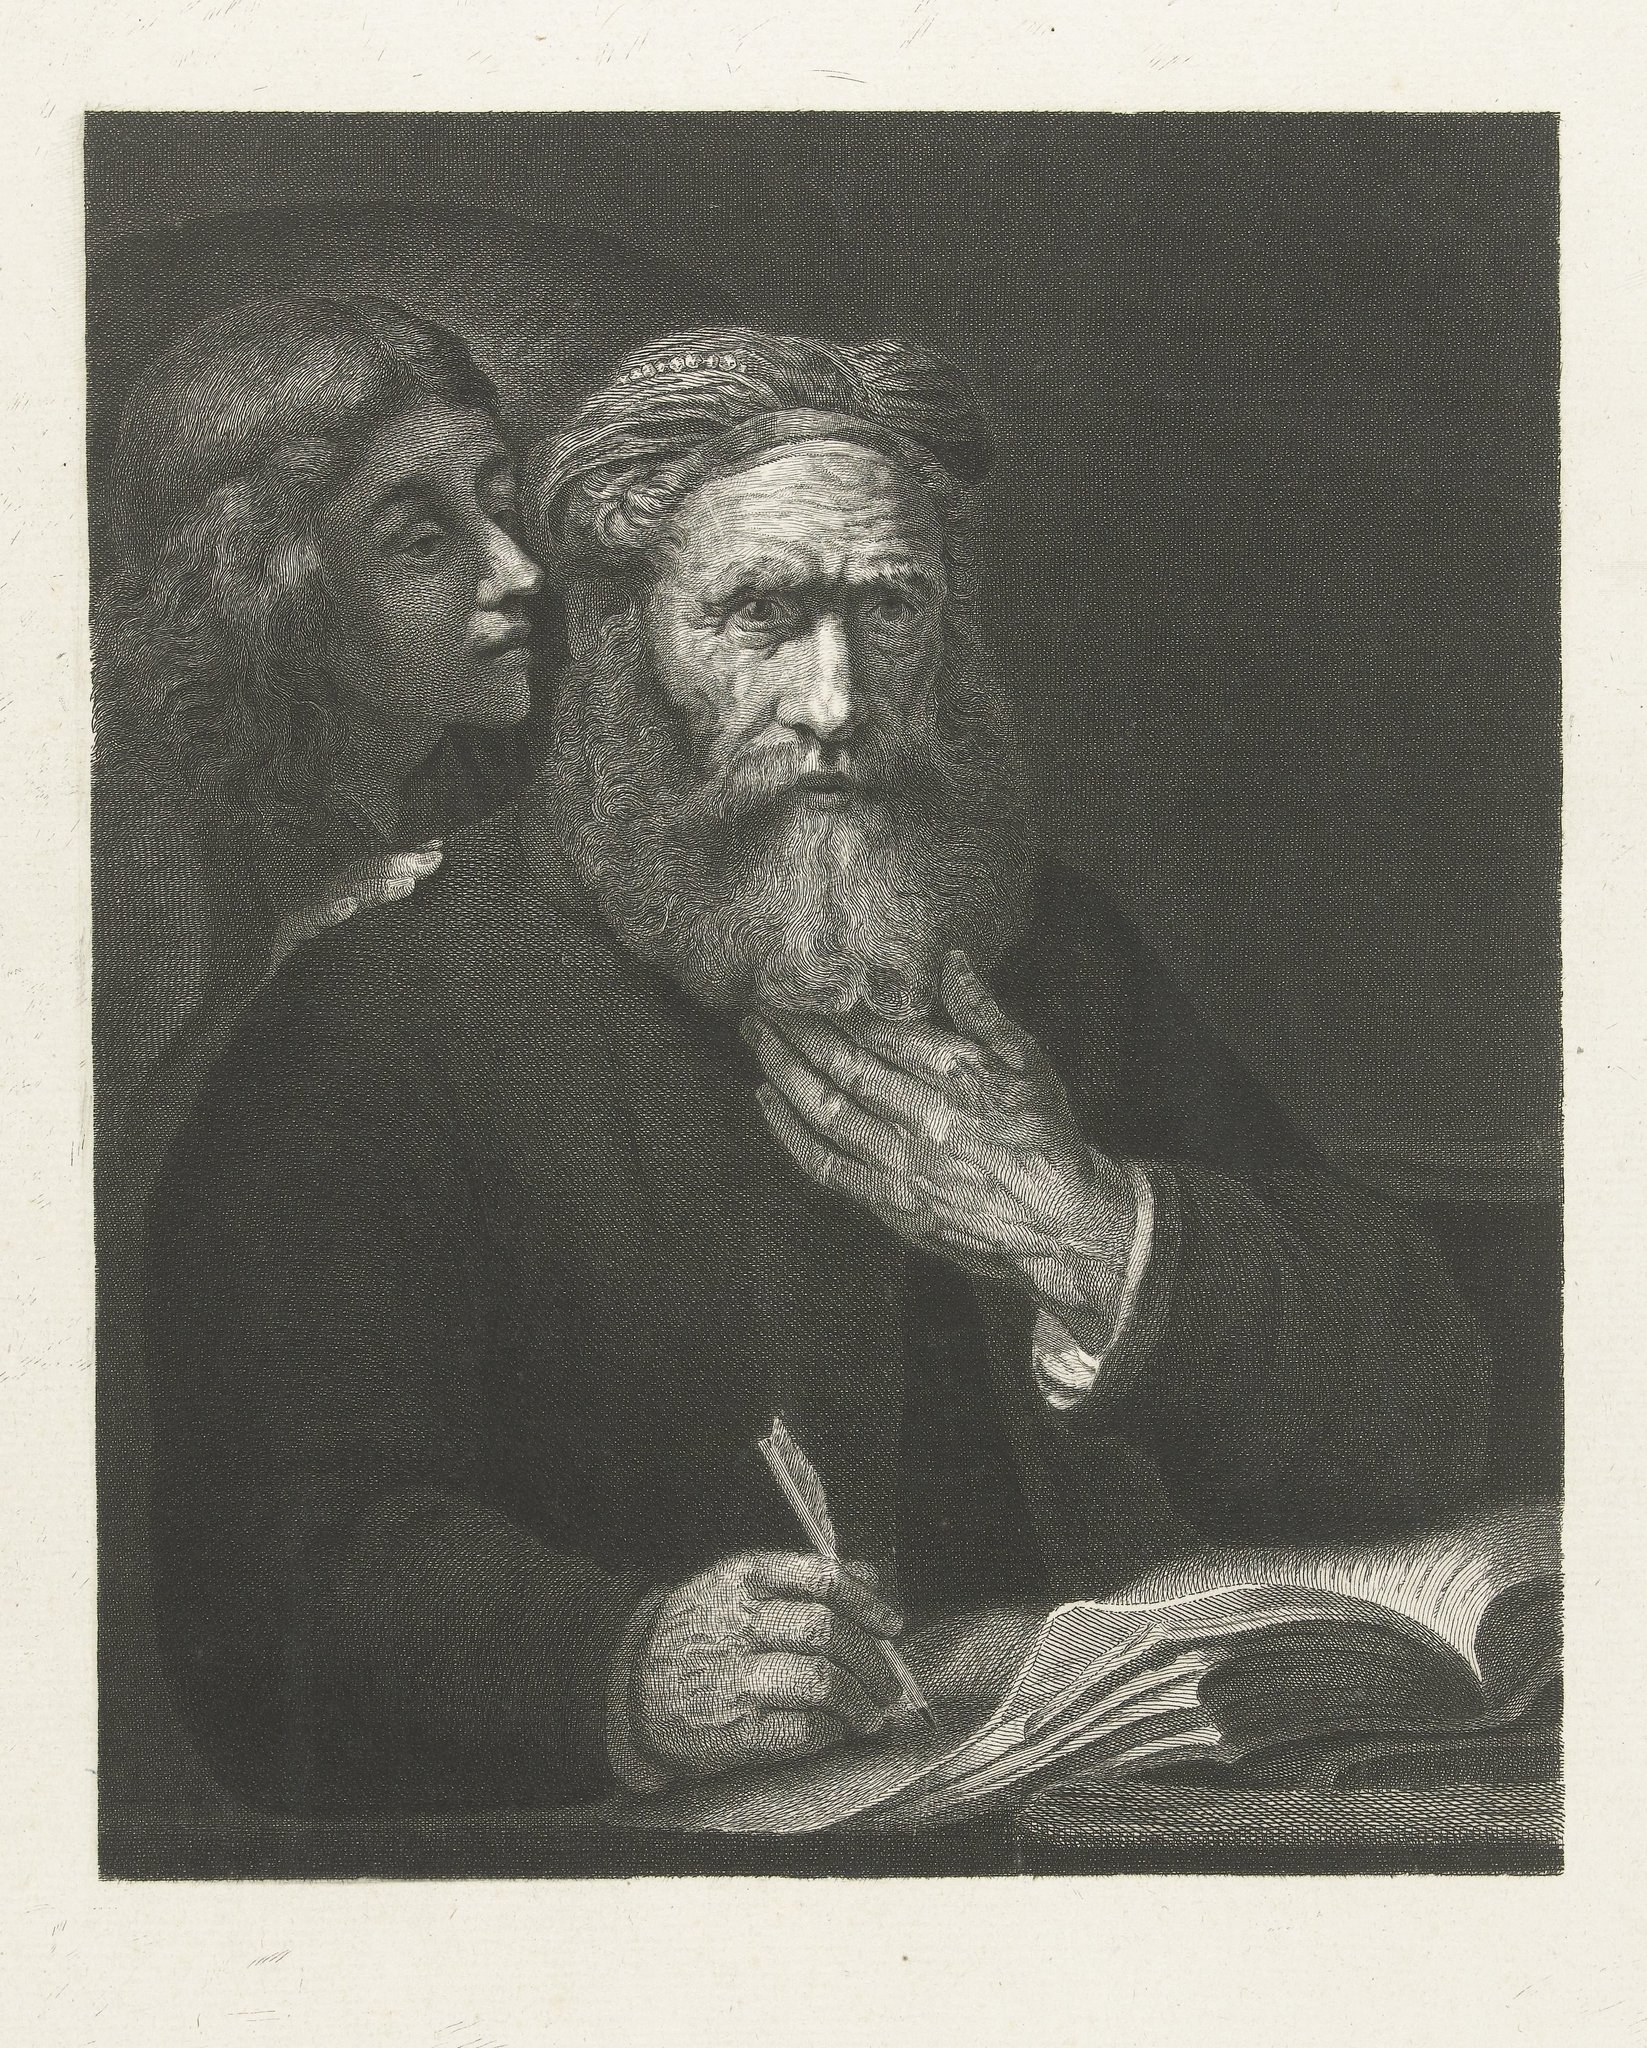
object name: print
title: Matteüs de evangelist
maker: lambertus antonius claessens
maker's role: draughtsman, print maker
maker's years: 1763-1834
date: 1808-1834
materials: paper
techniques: etching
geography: paris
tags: st. matthew writing the gospel, usually the angel present, dictating or assisting him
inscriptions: collector's mark: Lugt 2228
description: Gemaakt voor: Musée français : recueil des plus beaux tableaux, statues et bas-reliefs qui existaient au Louvre avant 1815, avec l'explication des sujets, et des discours historiques sur la peinture, la sculpture et la gravure. Paris: A. & W. Galignani & Londers, J.O. Robinson, [1829-39]